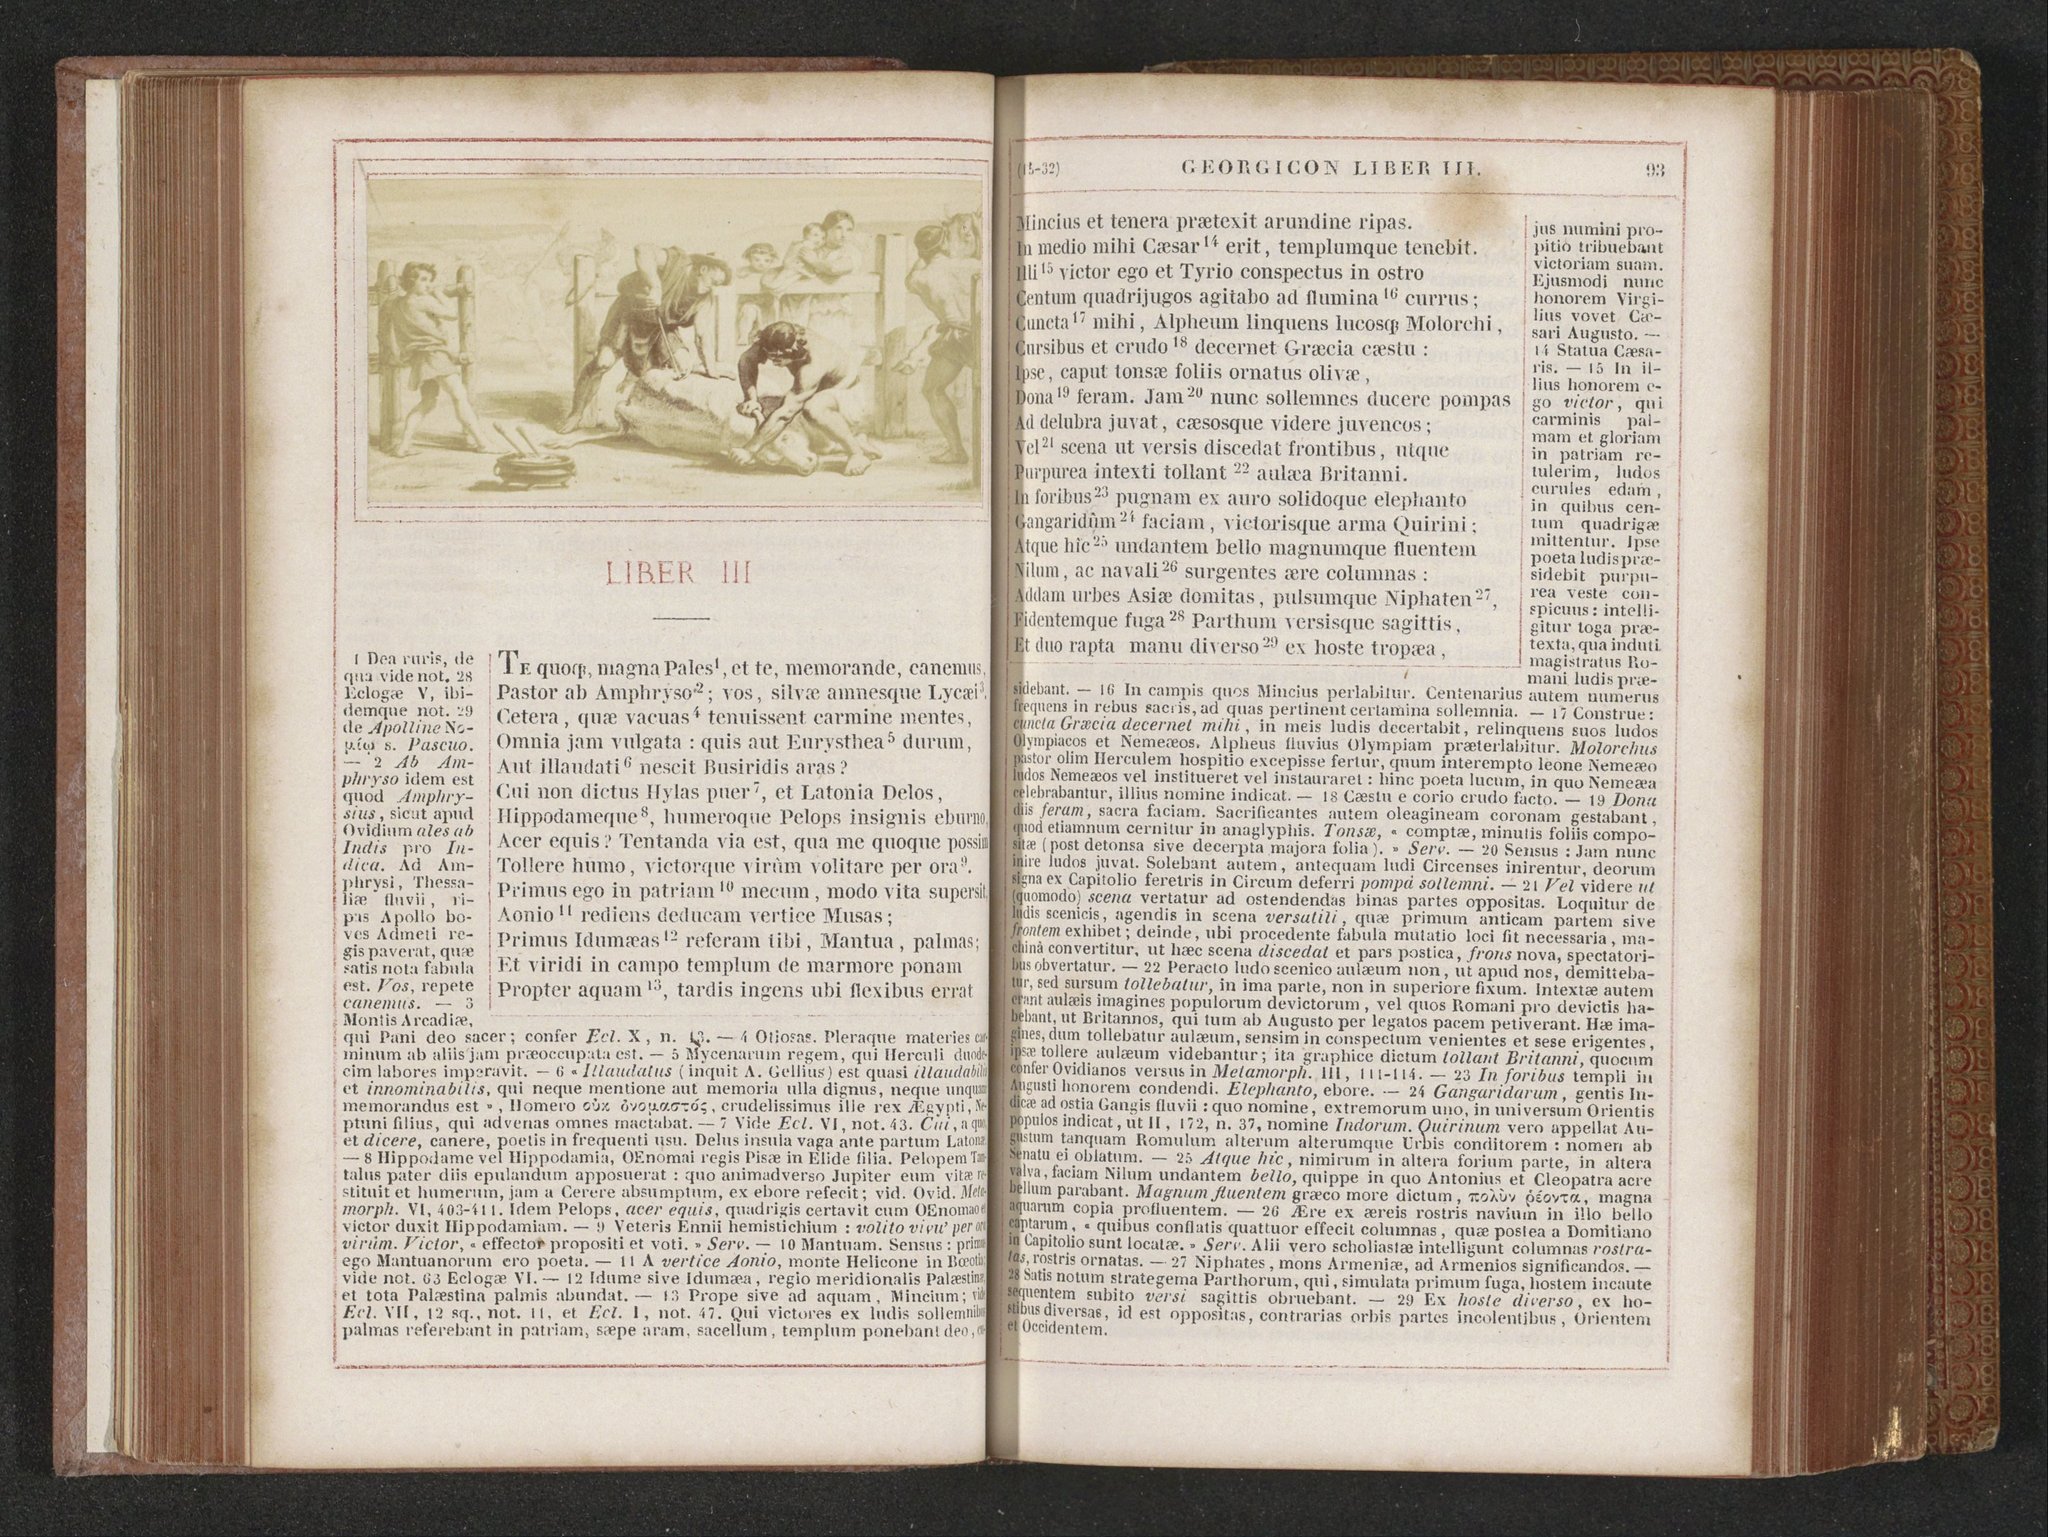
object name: page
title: Fotoreproductie van een schilderij, voorstellende het offeren van een os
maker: Anonymous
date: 1850-1858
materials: photographic support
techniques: albumen print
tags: slaughtered ox or pig